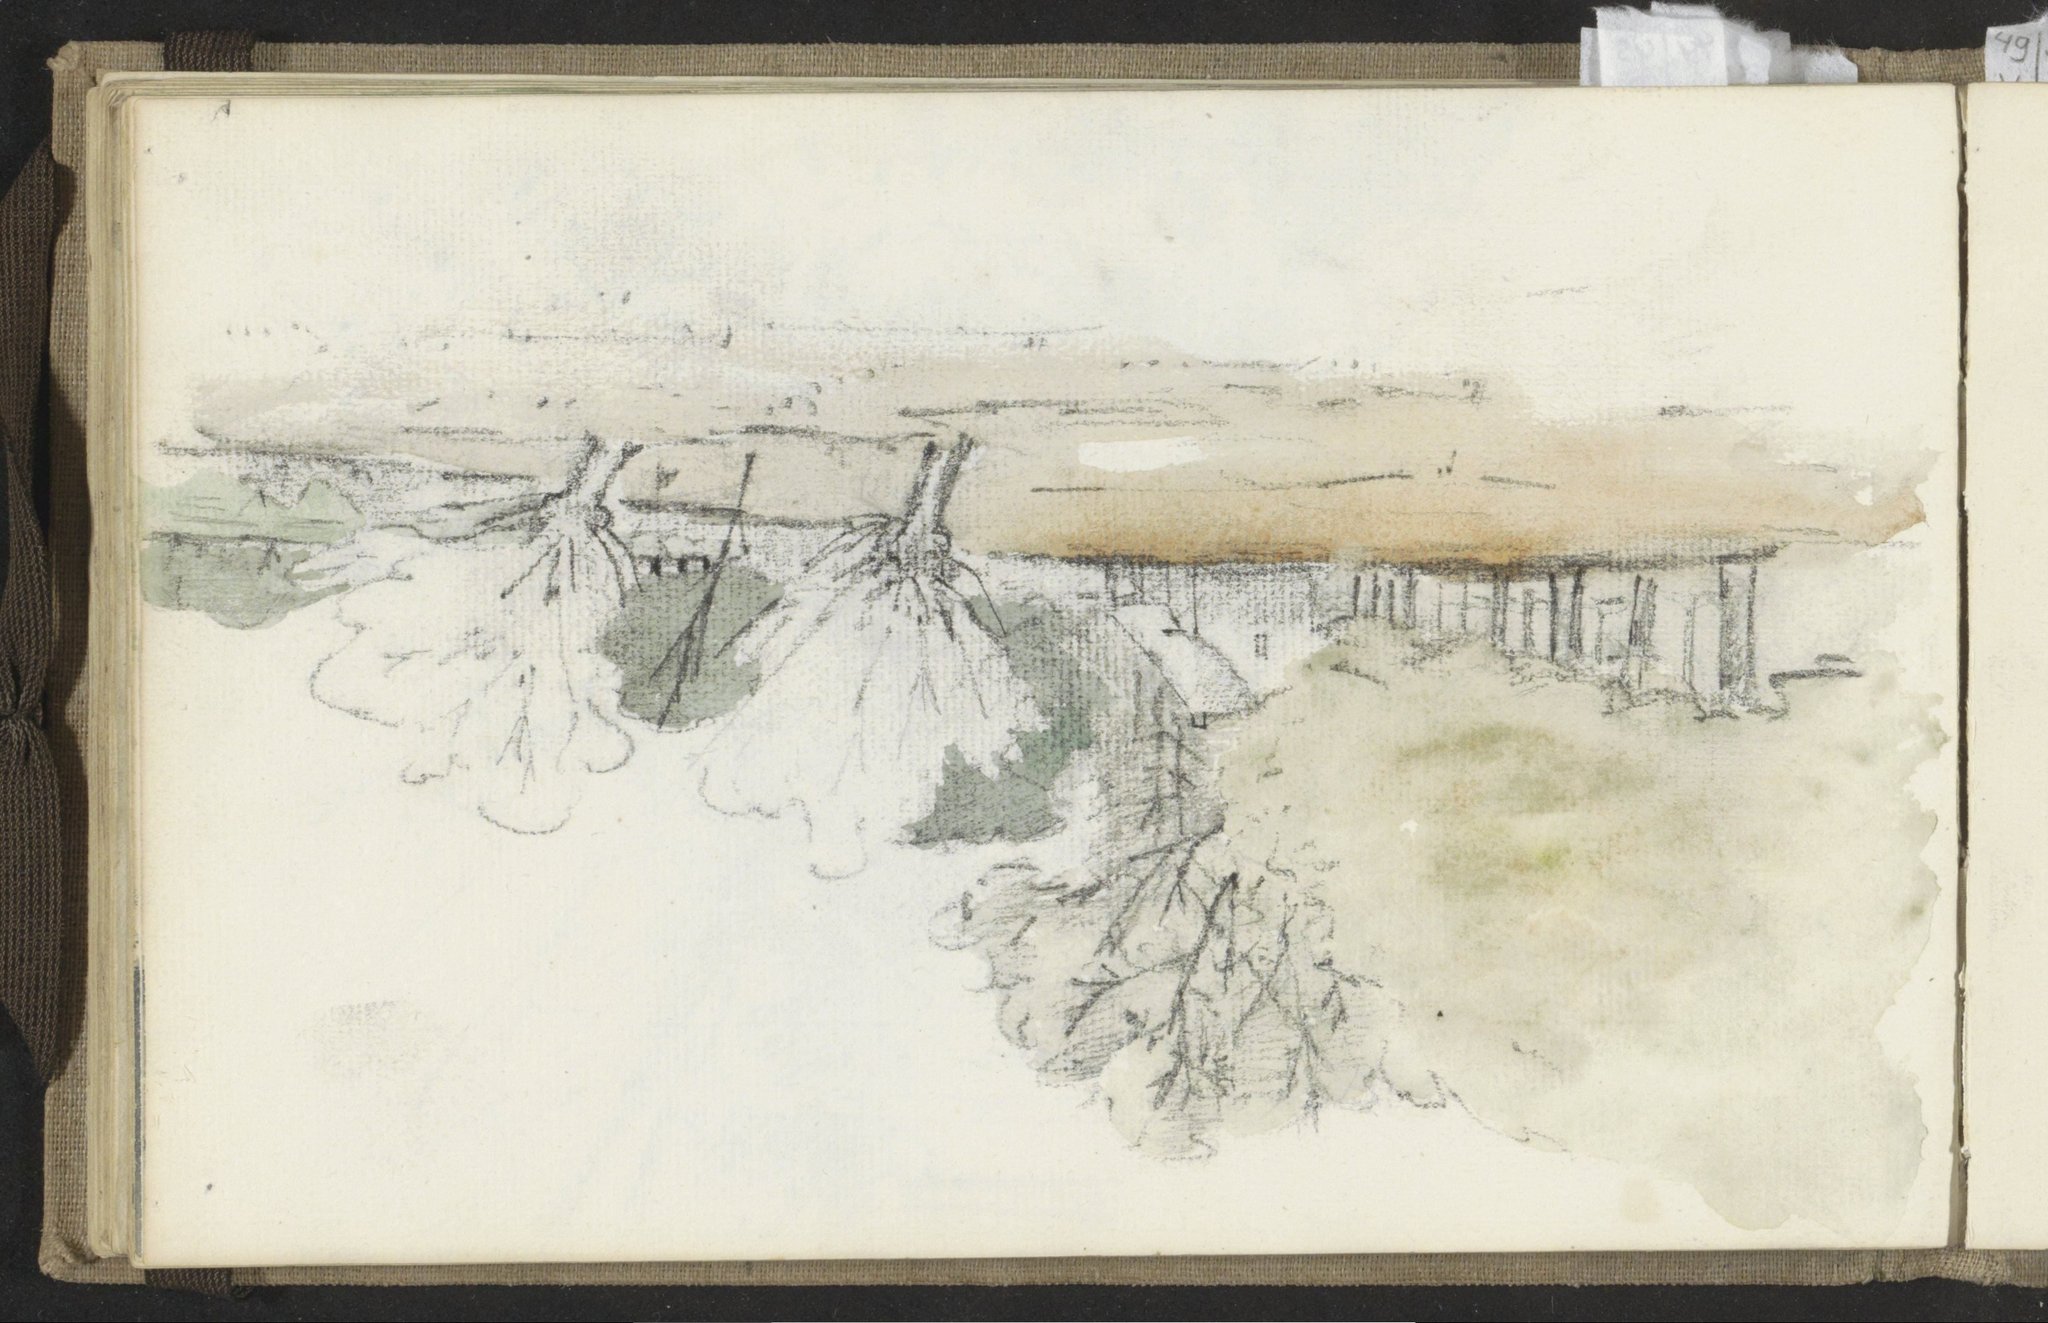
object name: sketchbook leaf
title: Landschap met bomen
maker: jonkheer johannes ludovicus paulus bosch van drakestein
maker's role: draughtsman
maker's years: 1865-1929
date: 1896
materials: paper, pencil, watercolor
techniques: brush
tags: trees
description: Blad 46 verso uit een schetsboek met 58 bladen.